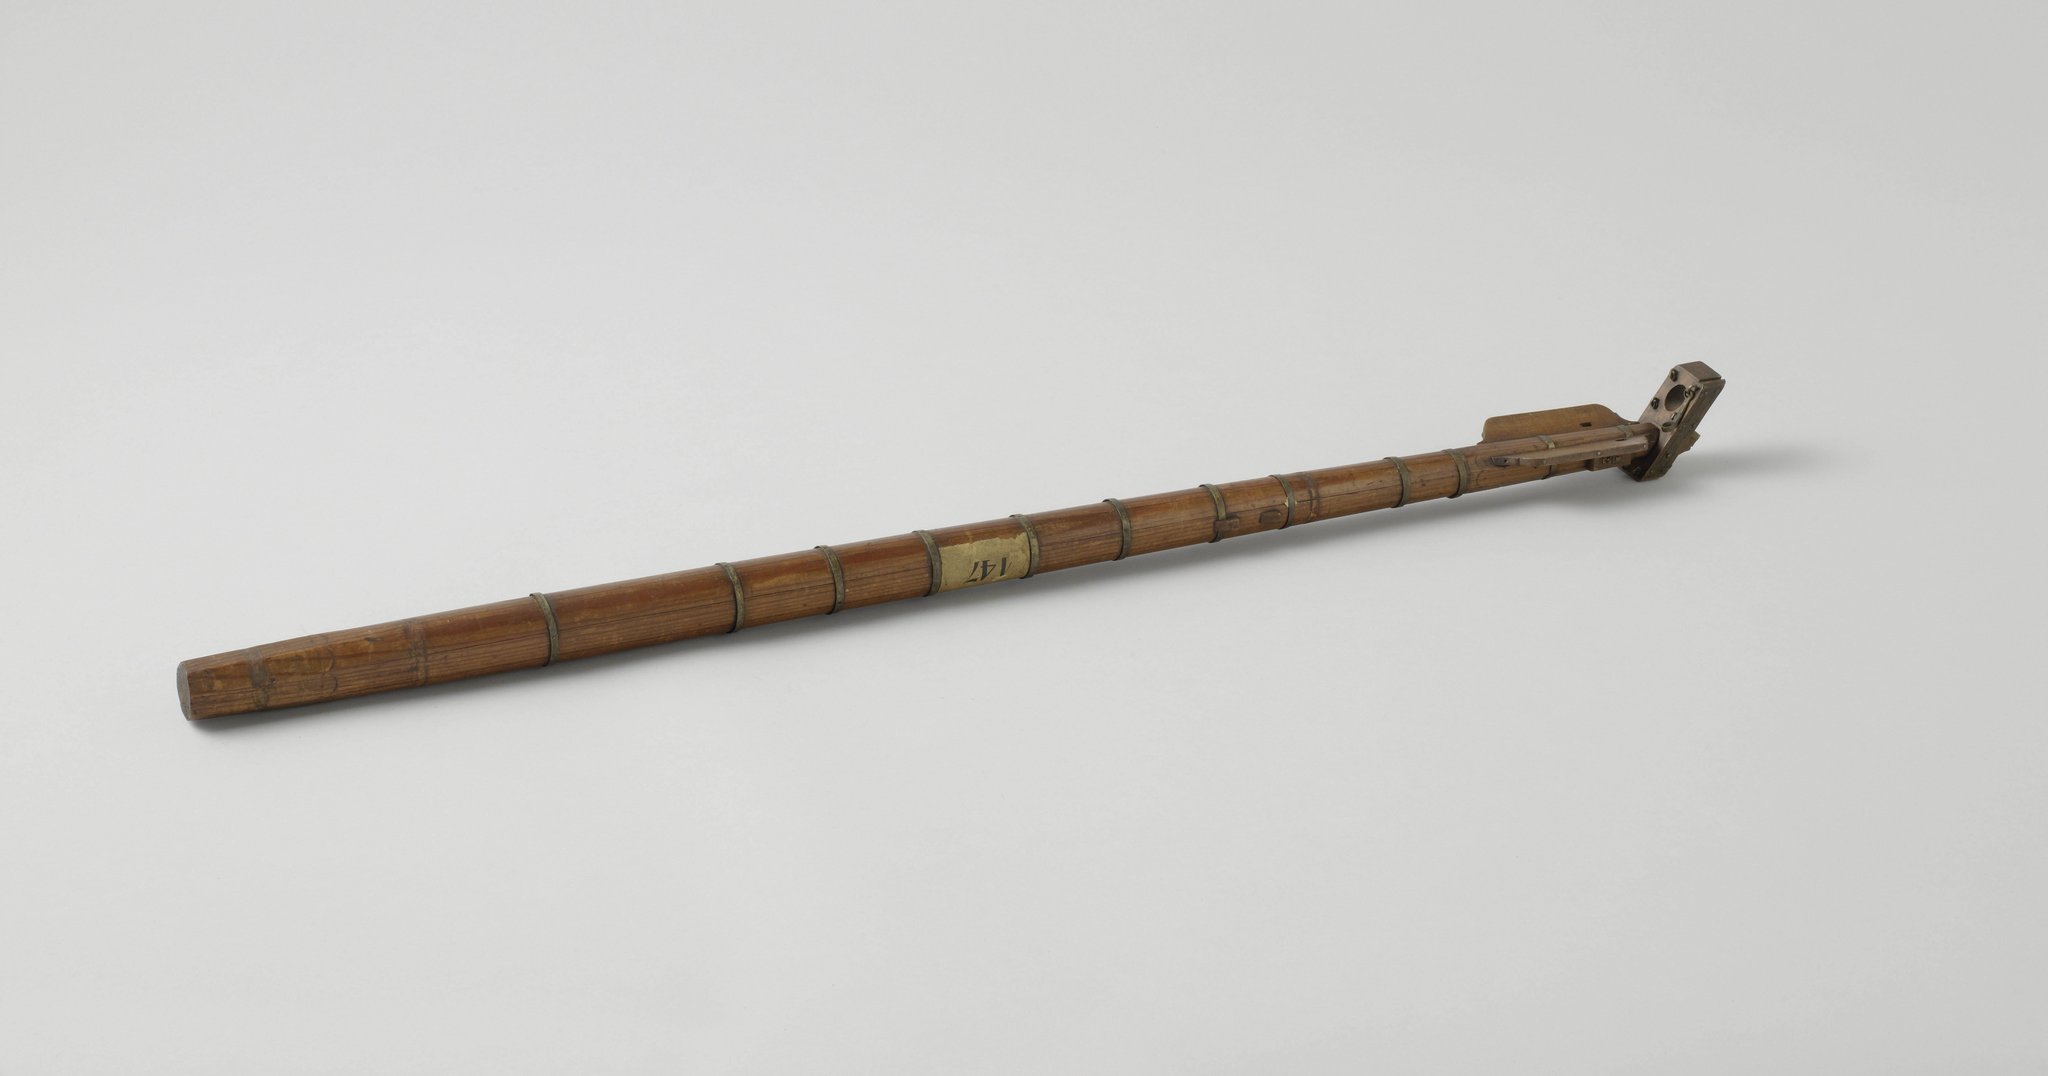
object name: demonstration model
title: Model of a Made Bowsprit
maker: Anonymous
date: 1800-1850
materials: brass, wood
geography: netherlands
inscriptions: label: ‘147’ former inventory label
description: Ronde boegspriet met schild en vioolstukken. De boegspriet heeft acht wangen, met kuipbanden tegen de koning geklemd. Op ongeveer tweederde van de lengte zijn aan weerszijden twee klampen voor de stroppen aangebracht. Aan beide zijden zit een vioolstuk met daaronder een schijf. Het schild heeft beugels voor de stampstok en de geussteng; aan de achterkant zijn ogen voor de loopstagen en ander stagen aangebracht.